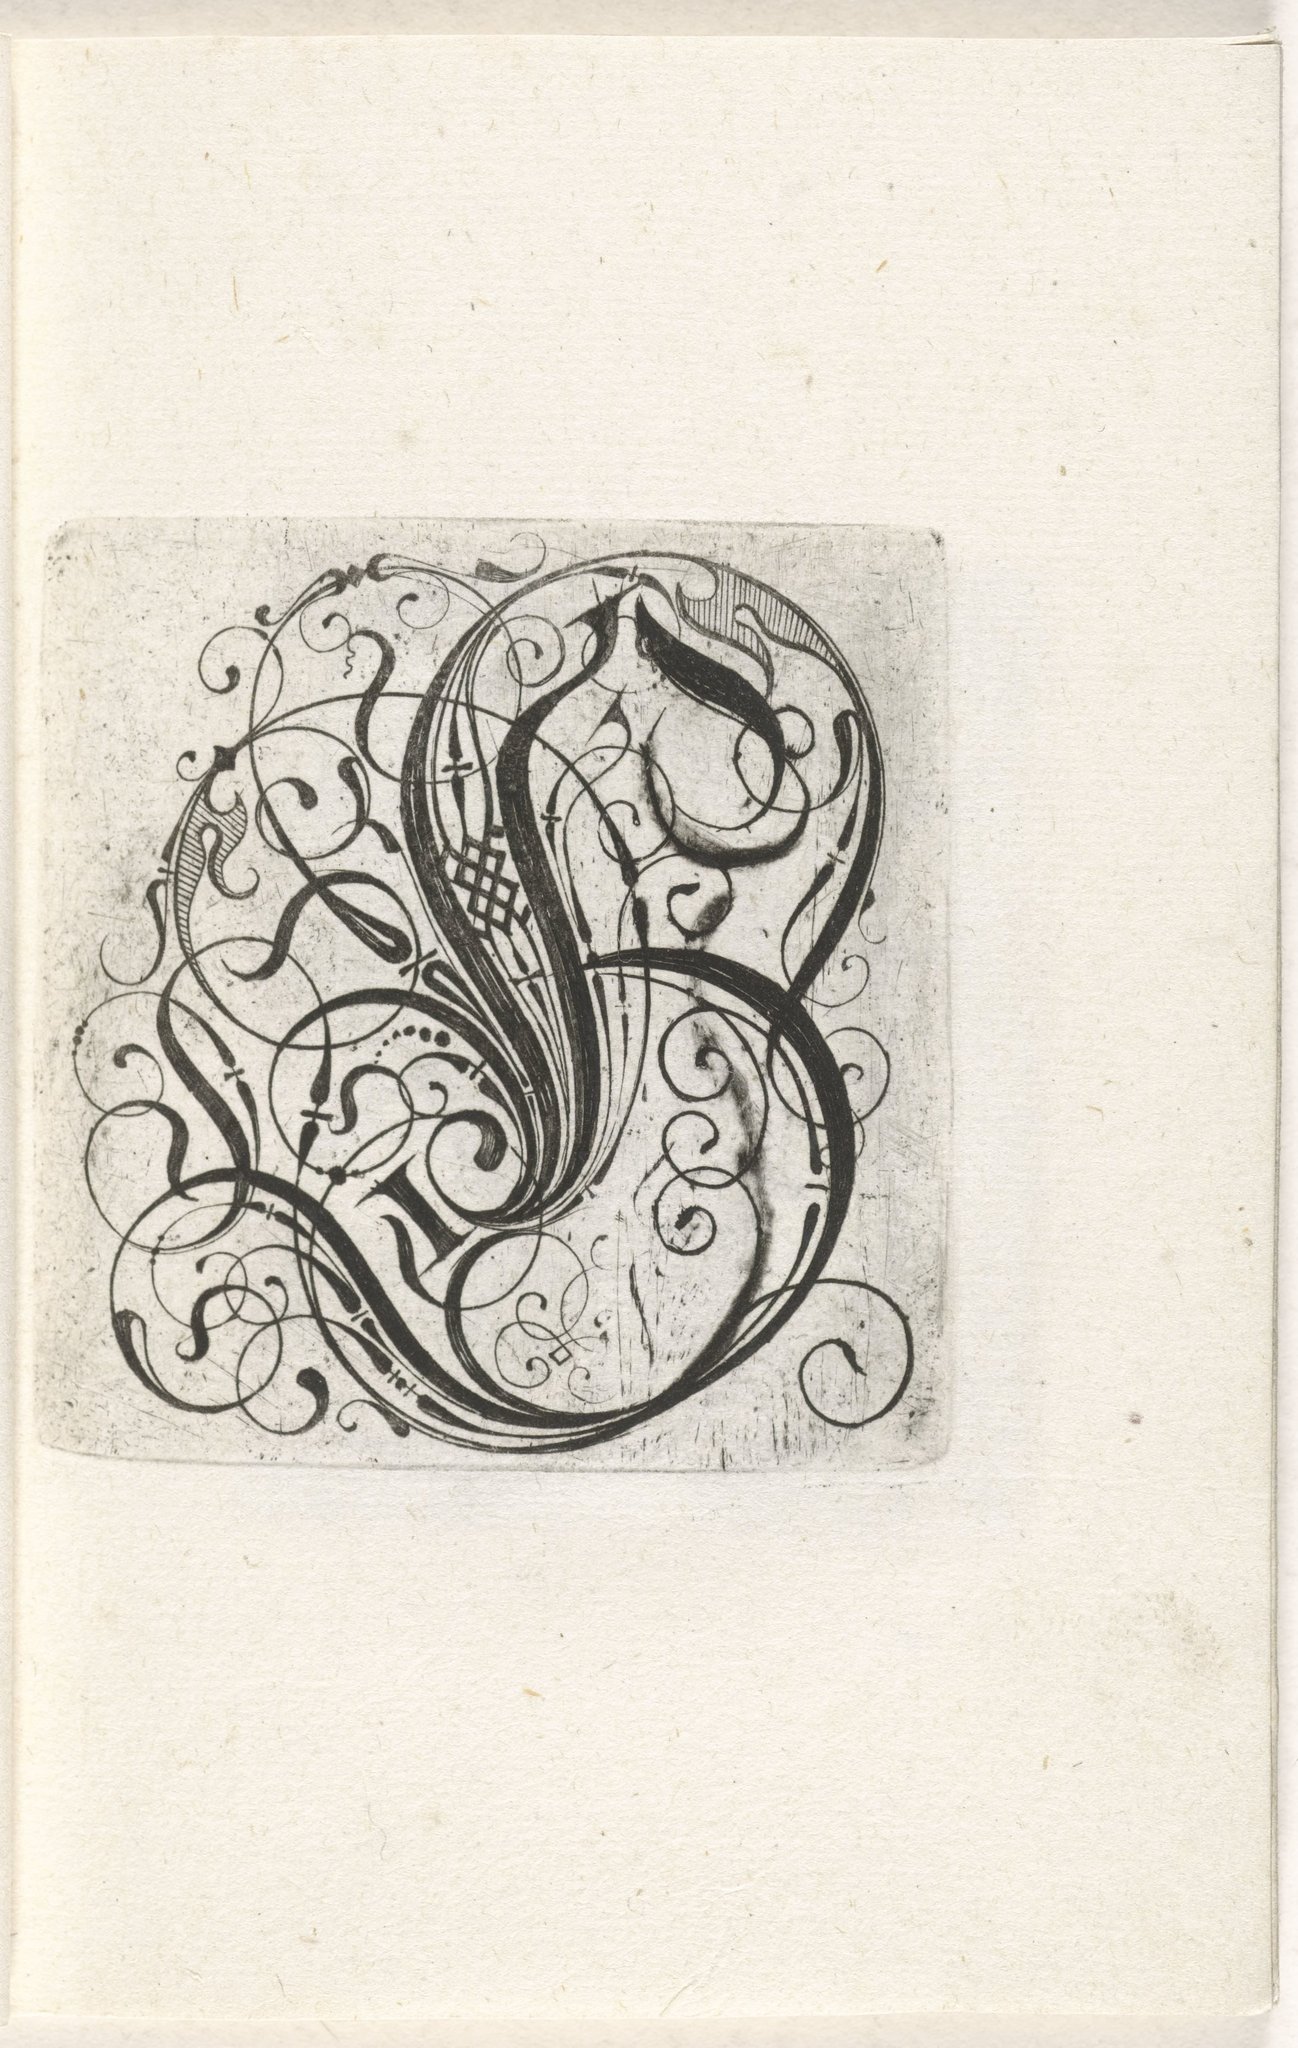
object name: print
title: Letter H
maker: Anonymous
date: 1600-1699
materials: paper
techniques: engraving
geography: netherlands